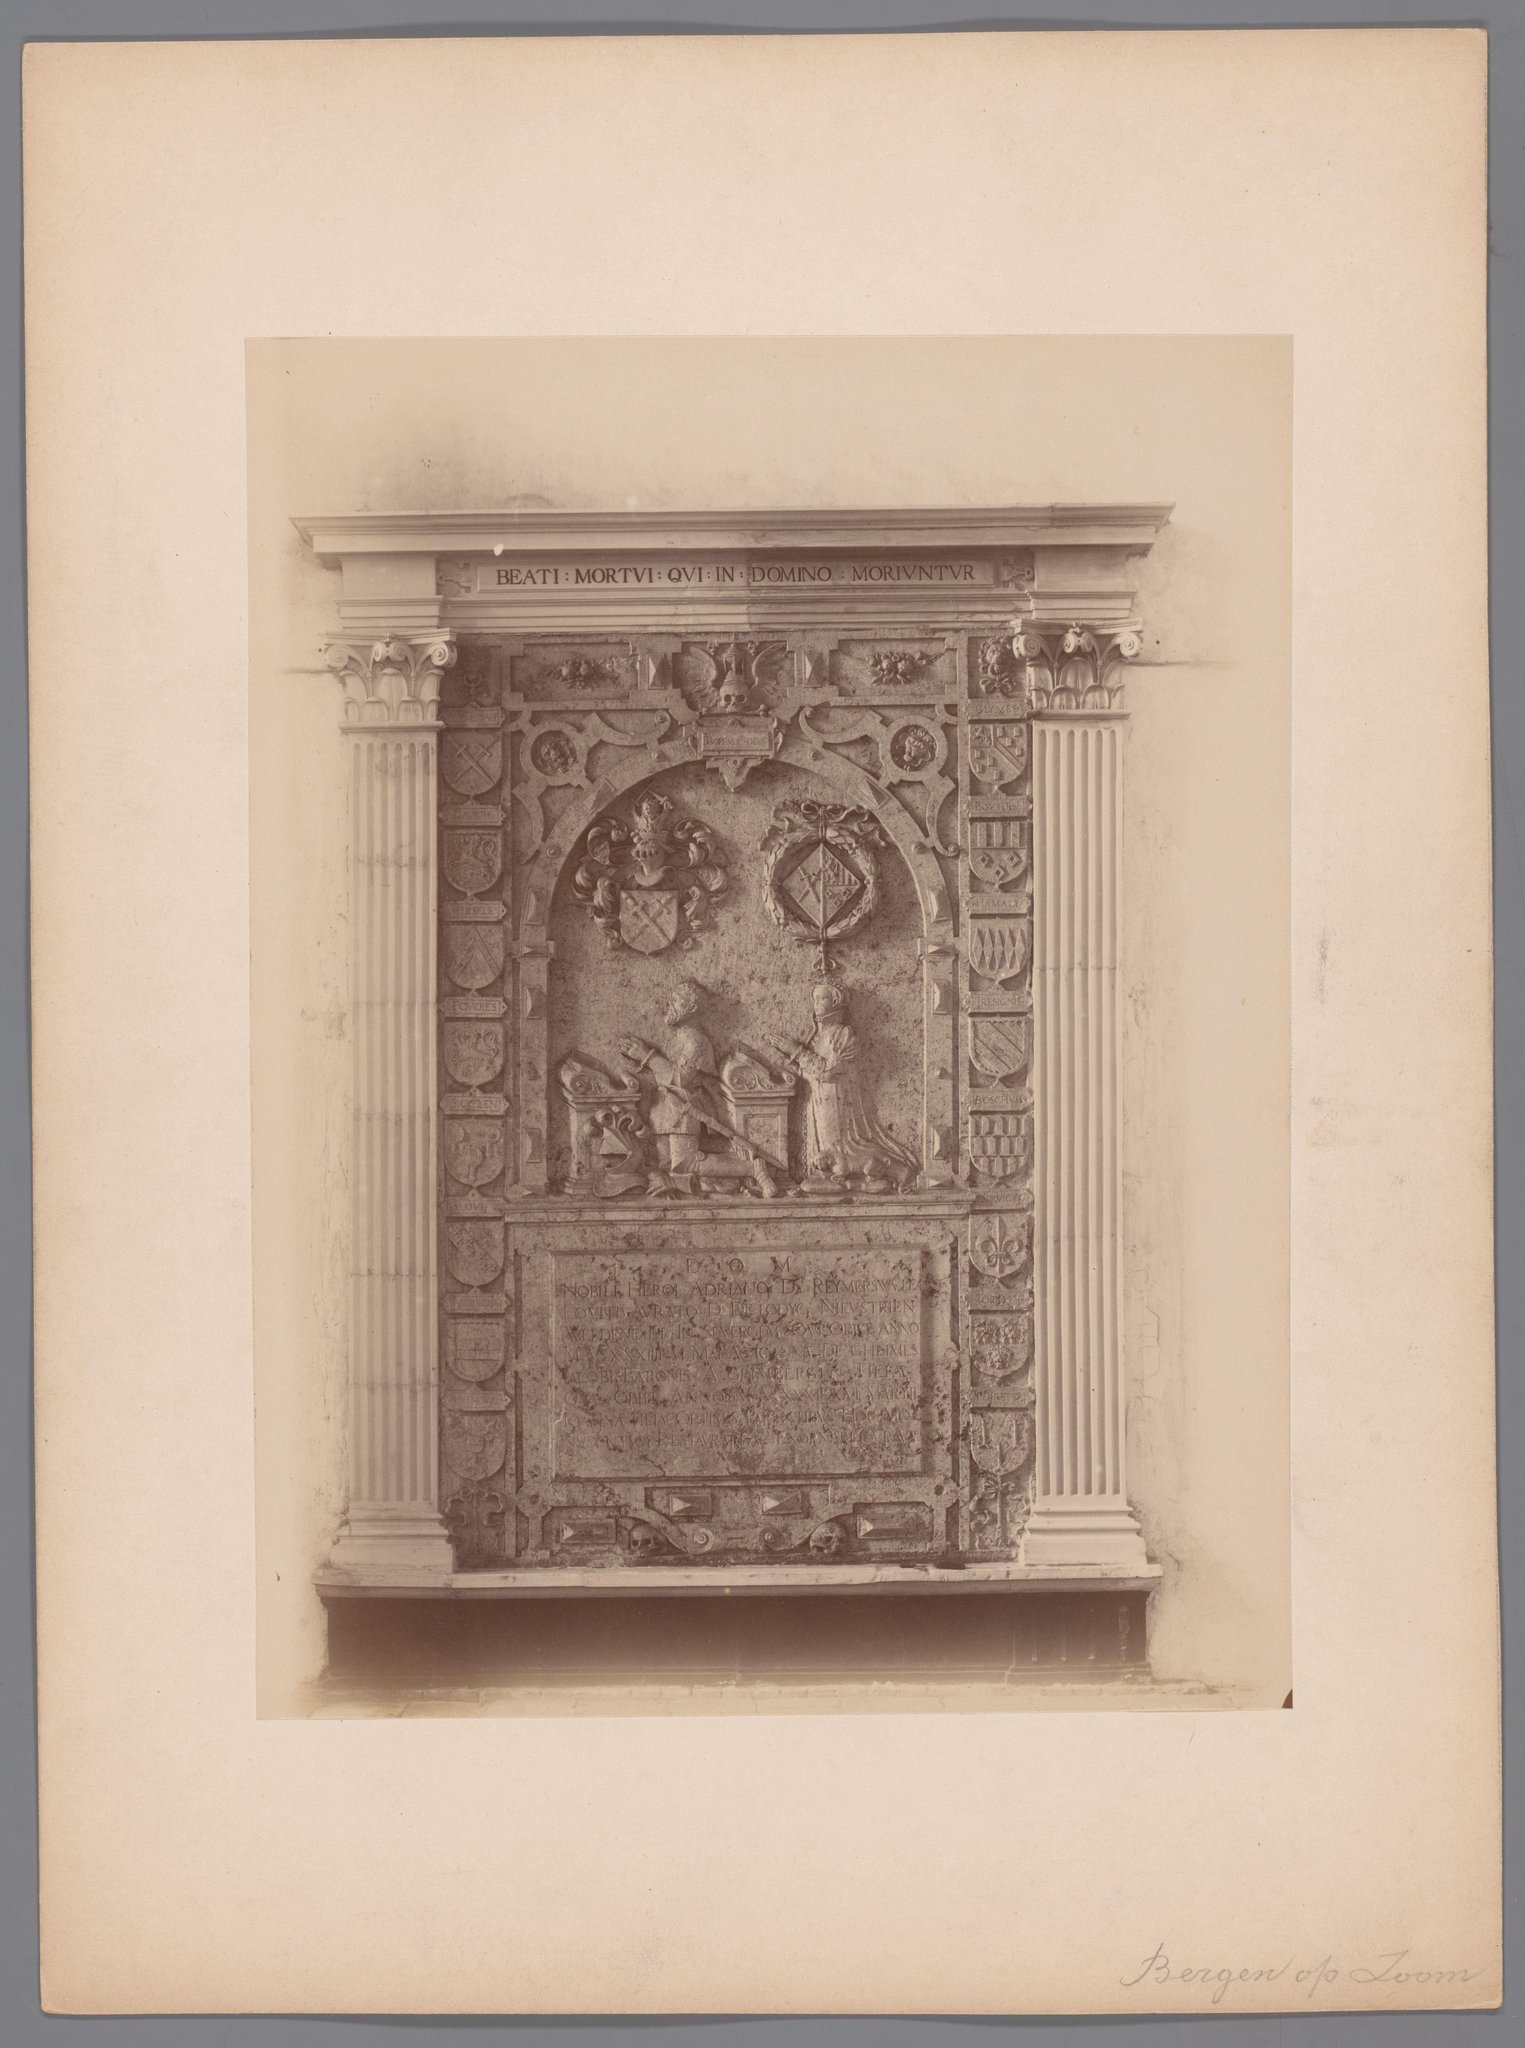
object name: photograph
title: Grafmonument van Adriaan van Reymerswaele in de Sint-Gertrudiskerk te Bergen op Zoom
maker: anoniem (monumentenzorg)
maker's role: fotograaf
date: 1890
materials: cardboard, photographic support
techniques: albumen print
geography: bergen op zoom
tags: bergen op zoom, grave-building, monumental tomb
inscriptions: annotation: ‘Bergen op Zoom’, annotation: ‘Grafmonument in de Kerk v/d N.H. gemeente te Bergen-op-Zoom/ sept 1890’